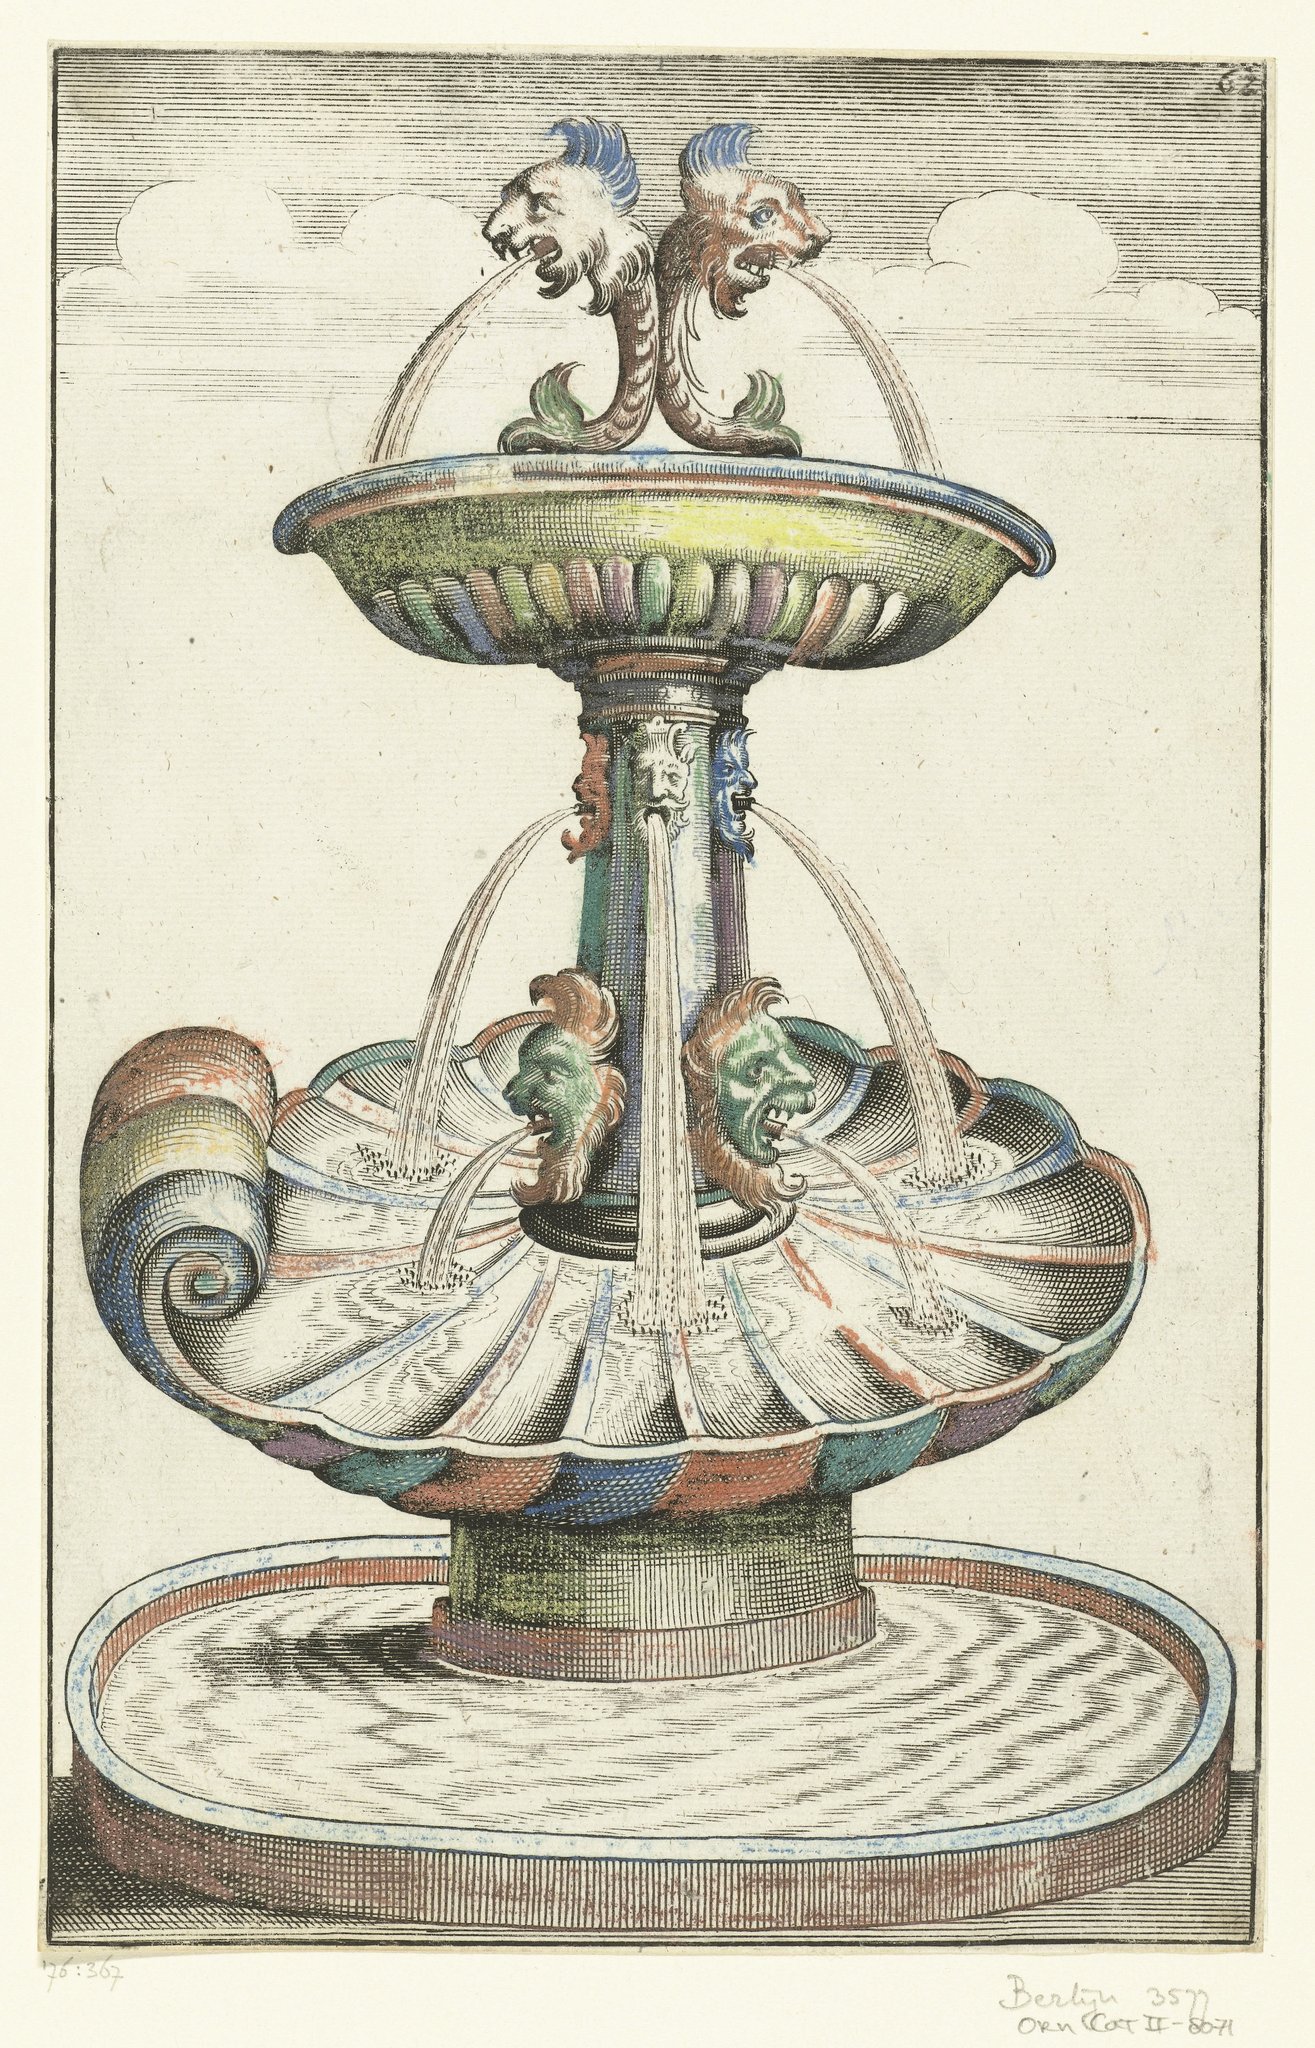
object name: ornament print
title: Architectura Curiosa Nova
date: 1664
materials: paper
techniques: etching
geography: nuremberg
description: In een rond bassin staat op een klein voetstuk een tweede, schelpvormig bassin. Hierin staat weer een voetstuk van een derde bassin, bestaande uit drie Toscaanse zuilen, gedecoreerd met maskers en leeuwenkoppen. In het derde bassin staan twee vissen met monsterhoofden. Blad 62 uit deel III van een serie bestaande uit 226 bladen, verdeeld over vier boeken, elk met een eigen titelblad.